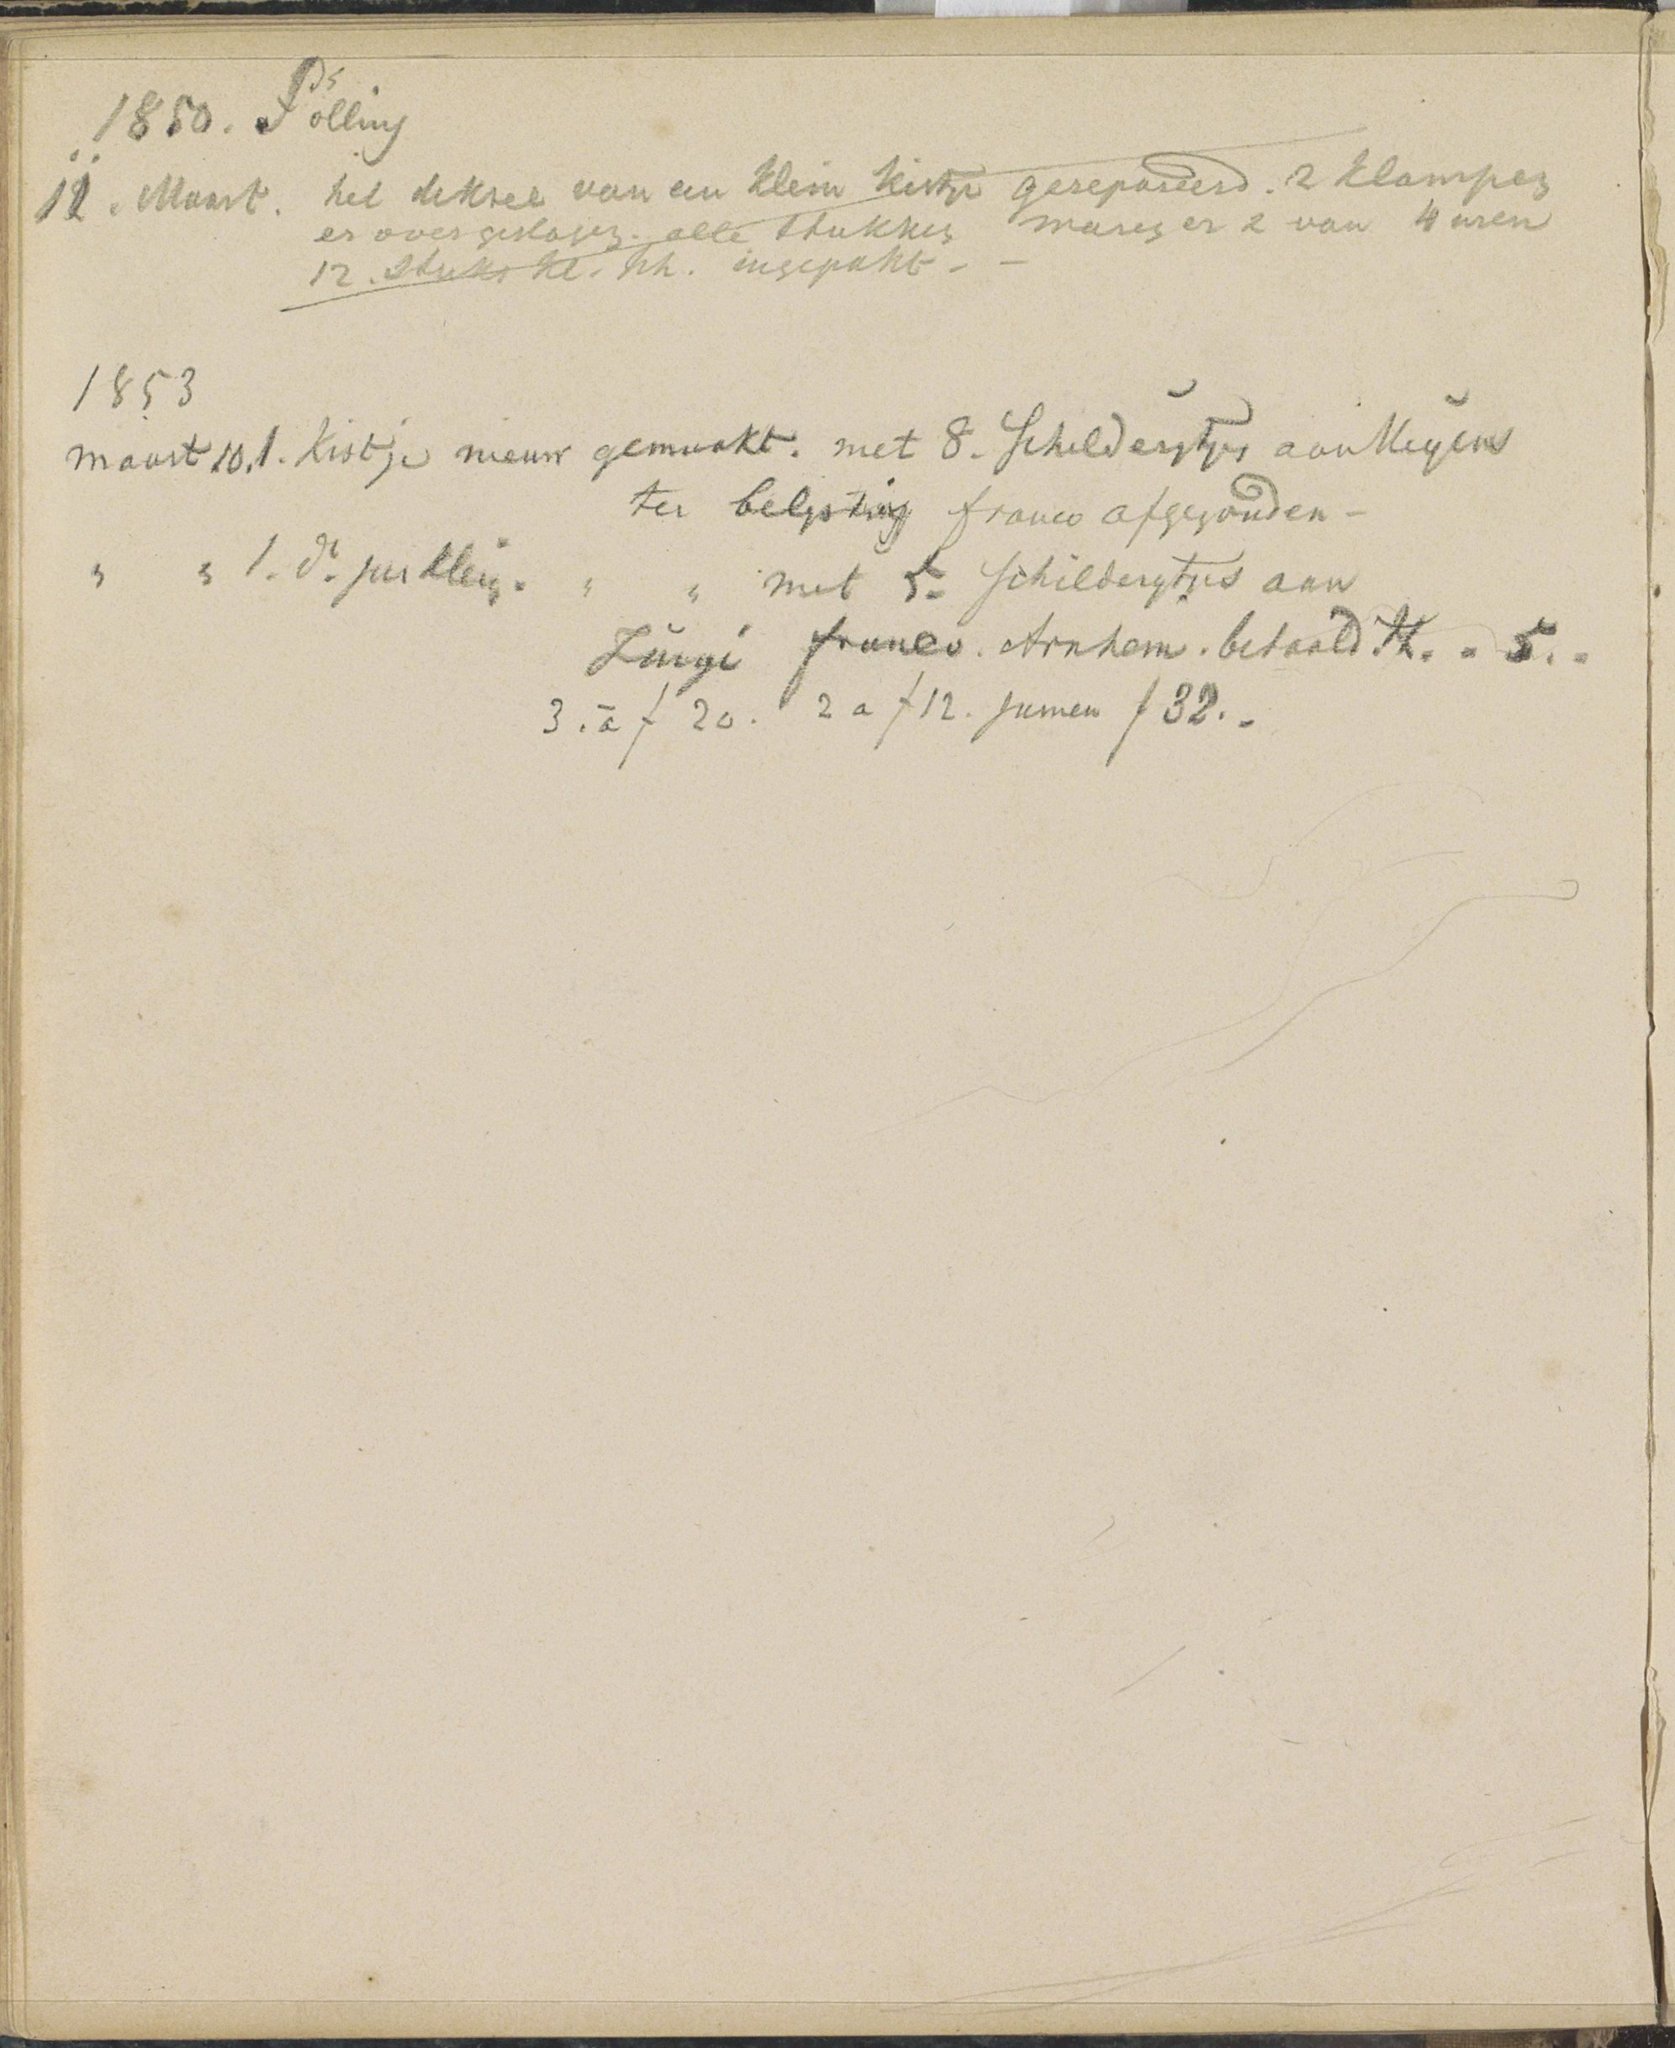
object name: sketchbook leaf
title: Notities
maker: johannes tavenraat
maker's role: draughtsman, painter, print maker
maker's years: 1809-1881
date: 1850-1853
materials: paper, pencil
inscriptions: annotation: ‘1850 folliny/ 12 Maart het deksel van een klein kistje gerepareerd [...]/ 1853/ maart [...] kistje nieuw gemaakt. met 8 schilderijtjes aan[...]en/ ter belijsting franco afge[...]nden [...]’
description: Blad 81 verso uit een schetsboek met 87 bladen.